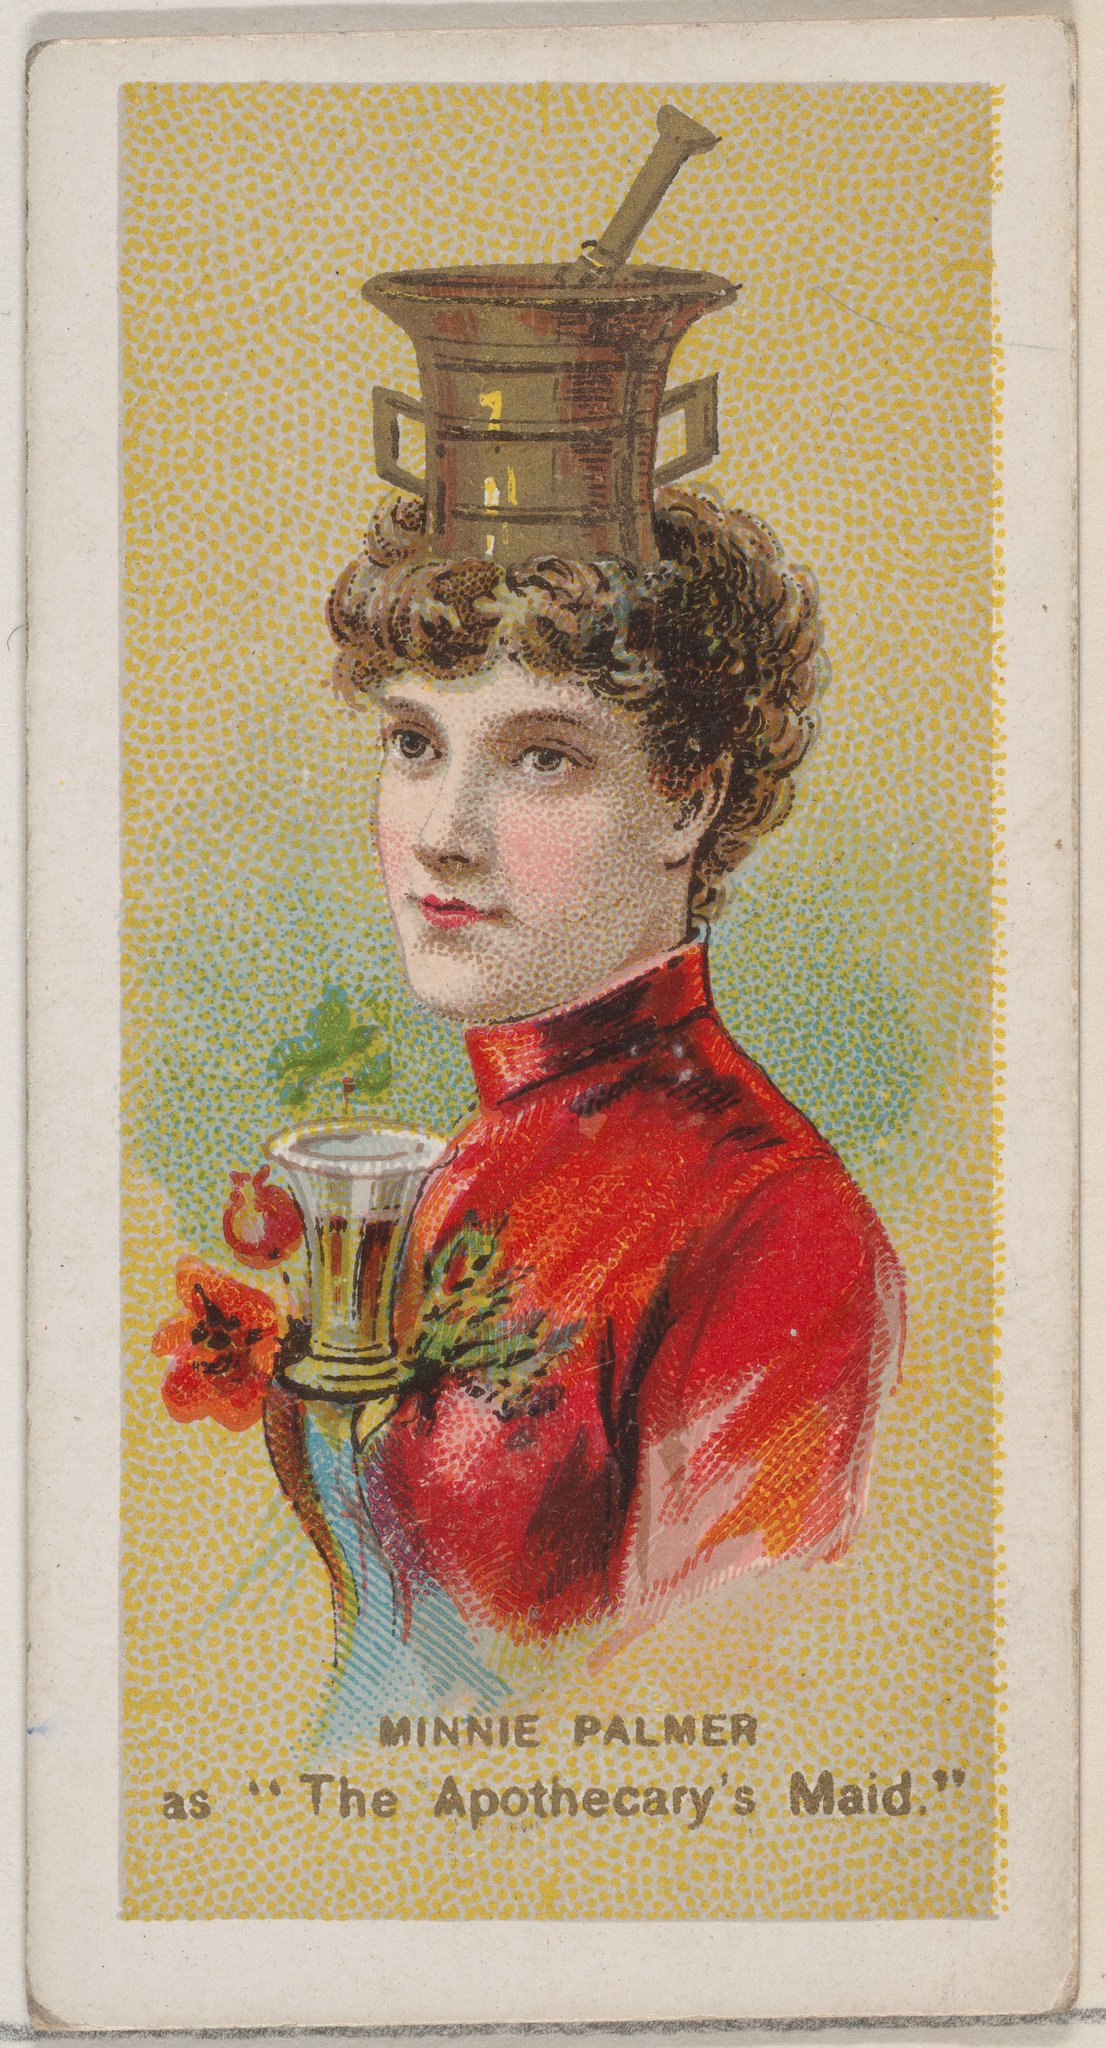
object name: print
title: Minnie Palmer as "The Apothecary's Maid," from the series Fancy Dress Ball Costumes (N73) for Duke brand cigarettes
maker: w. duke, sons & co.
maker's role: publisher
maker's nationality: american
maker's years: 1870-1920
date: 1889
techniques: color lithograph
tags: women,actresses